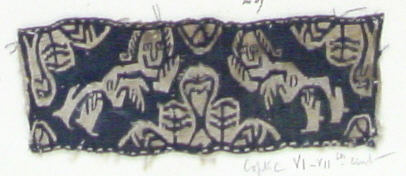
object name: textile fragment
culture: coptic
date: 501-700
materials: linen, wool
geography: egypt